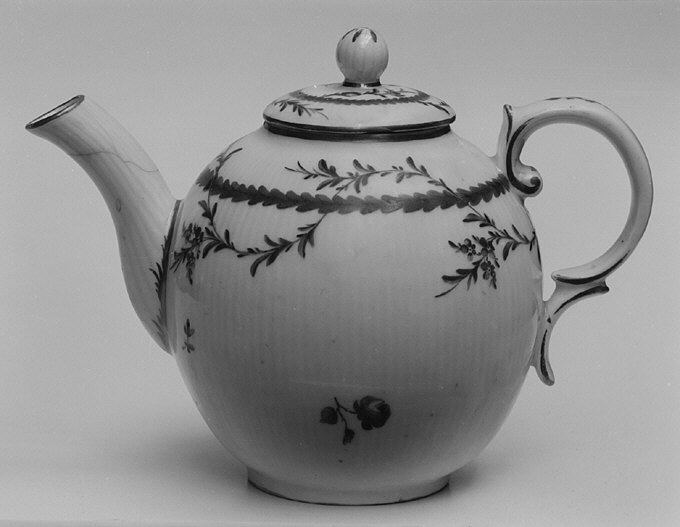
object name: teapot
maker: loosdrecht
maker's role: factory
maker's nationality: dutch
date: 1780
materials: hard paste porcelain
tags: flowers